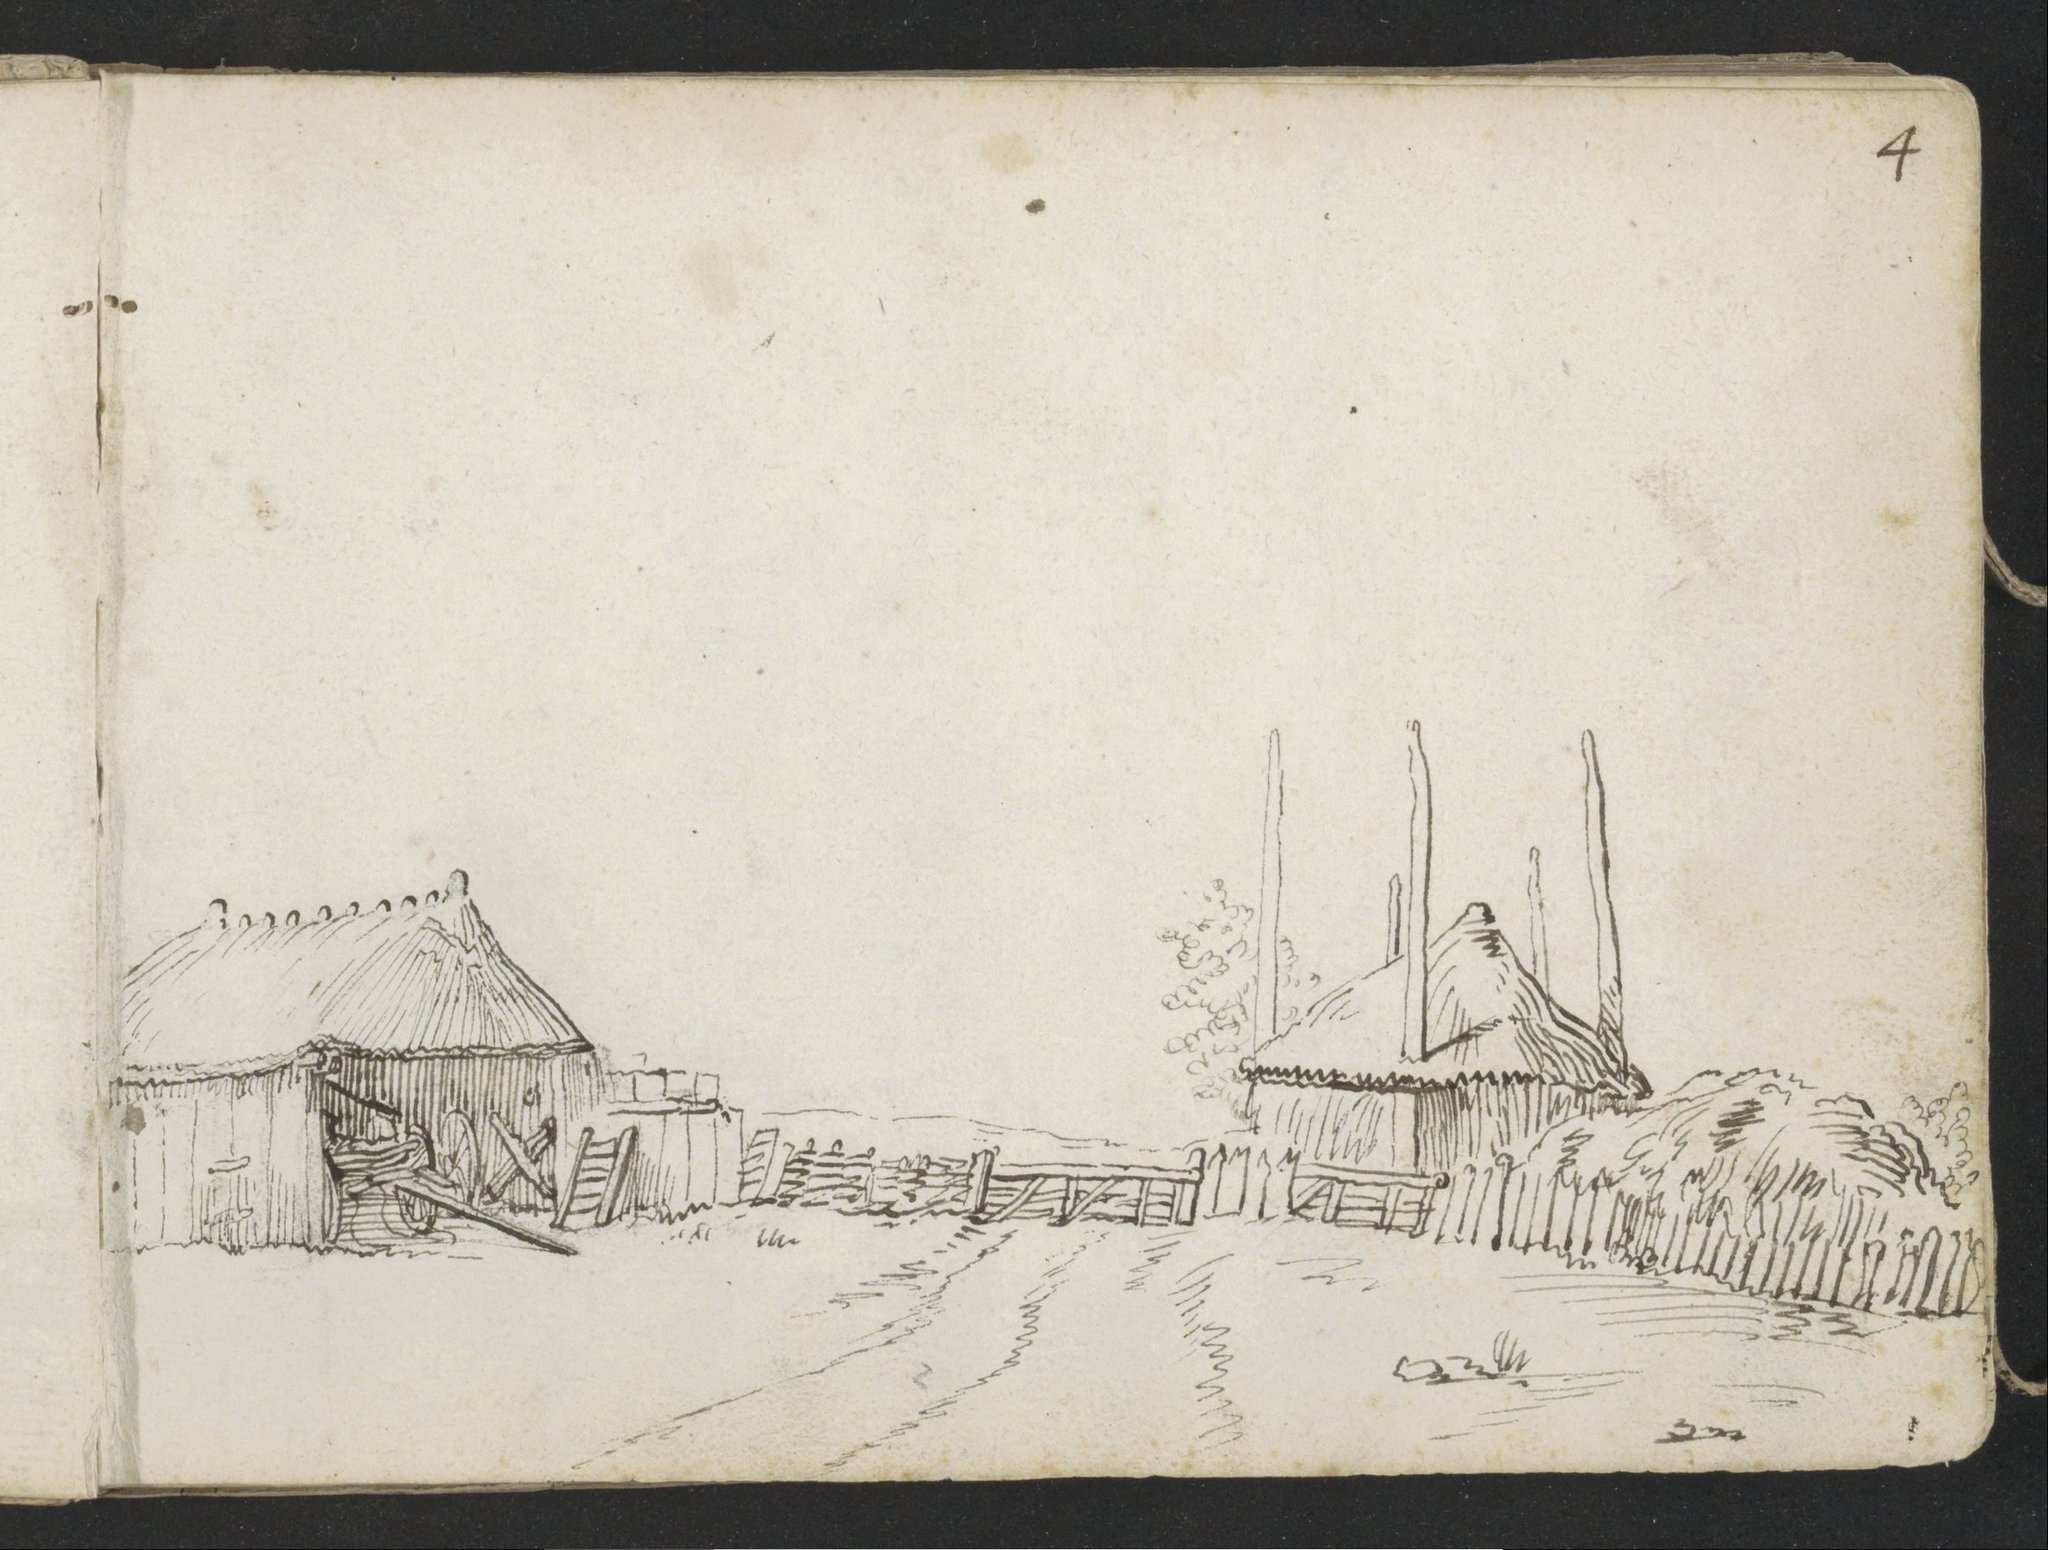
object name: sketchbook leaf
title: Boerenschuur en een hooistapel buiten Zwolle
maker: gerard ter borch (ii)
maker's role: draughtsman, painter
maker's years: 1617-1681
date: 1631-1633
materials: ink, paper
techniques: pen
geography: zwolle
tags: shed, hay-stack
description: In de boerenschuur staan een kar en werktuigen. Blad 4 recto uit een schetsboek met 55 bladen.